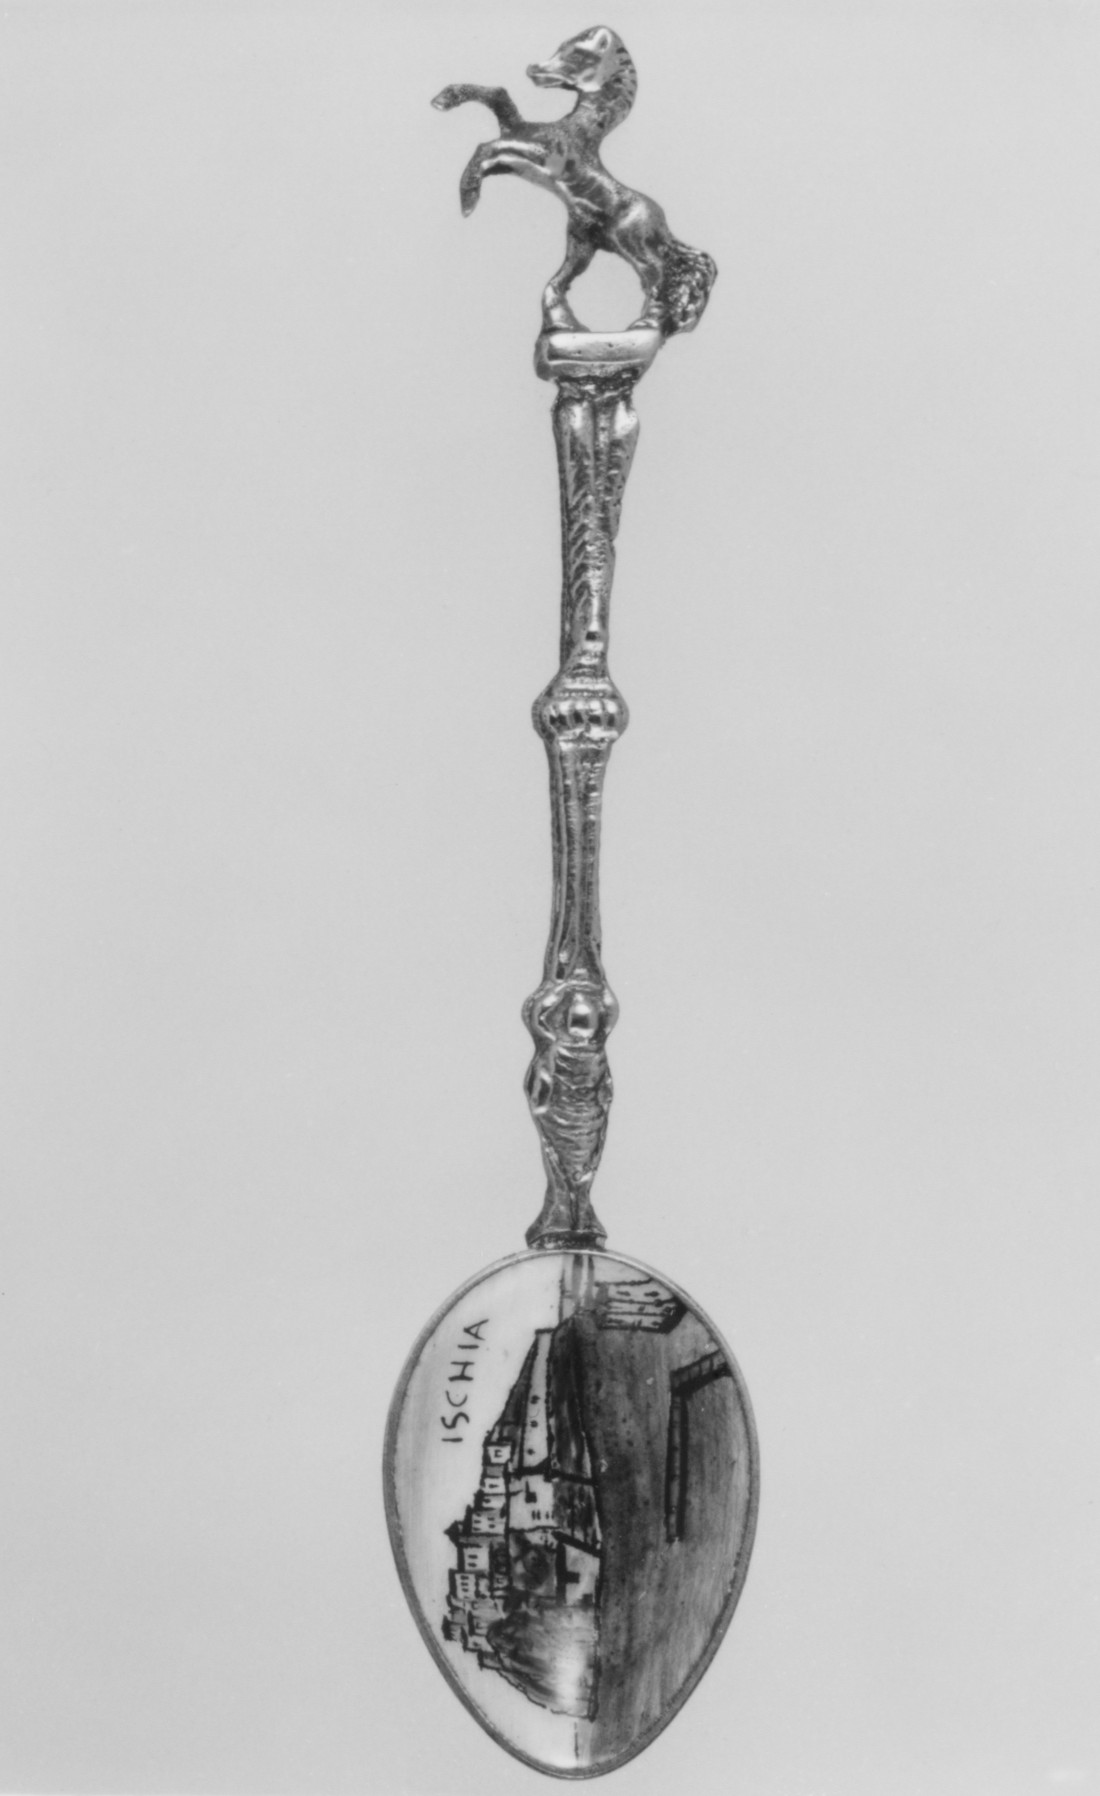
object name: souvenir spoon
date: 1867-1900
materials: silver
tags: horses